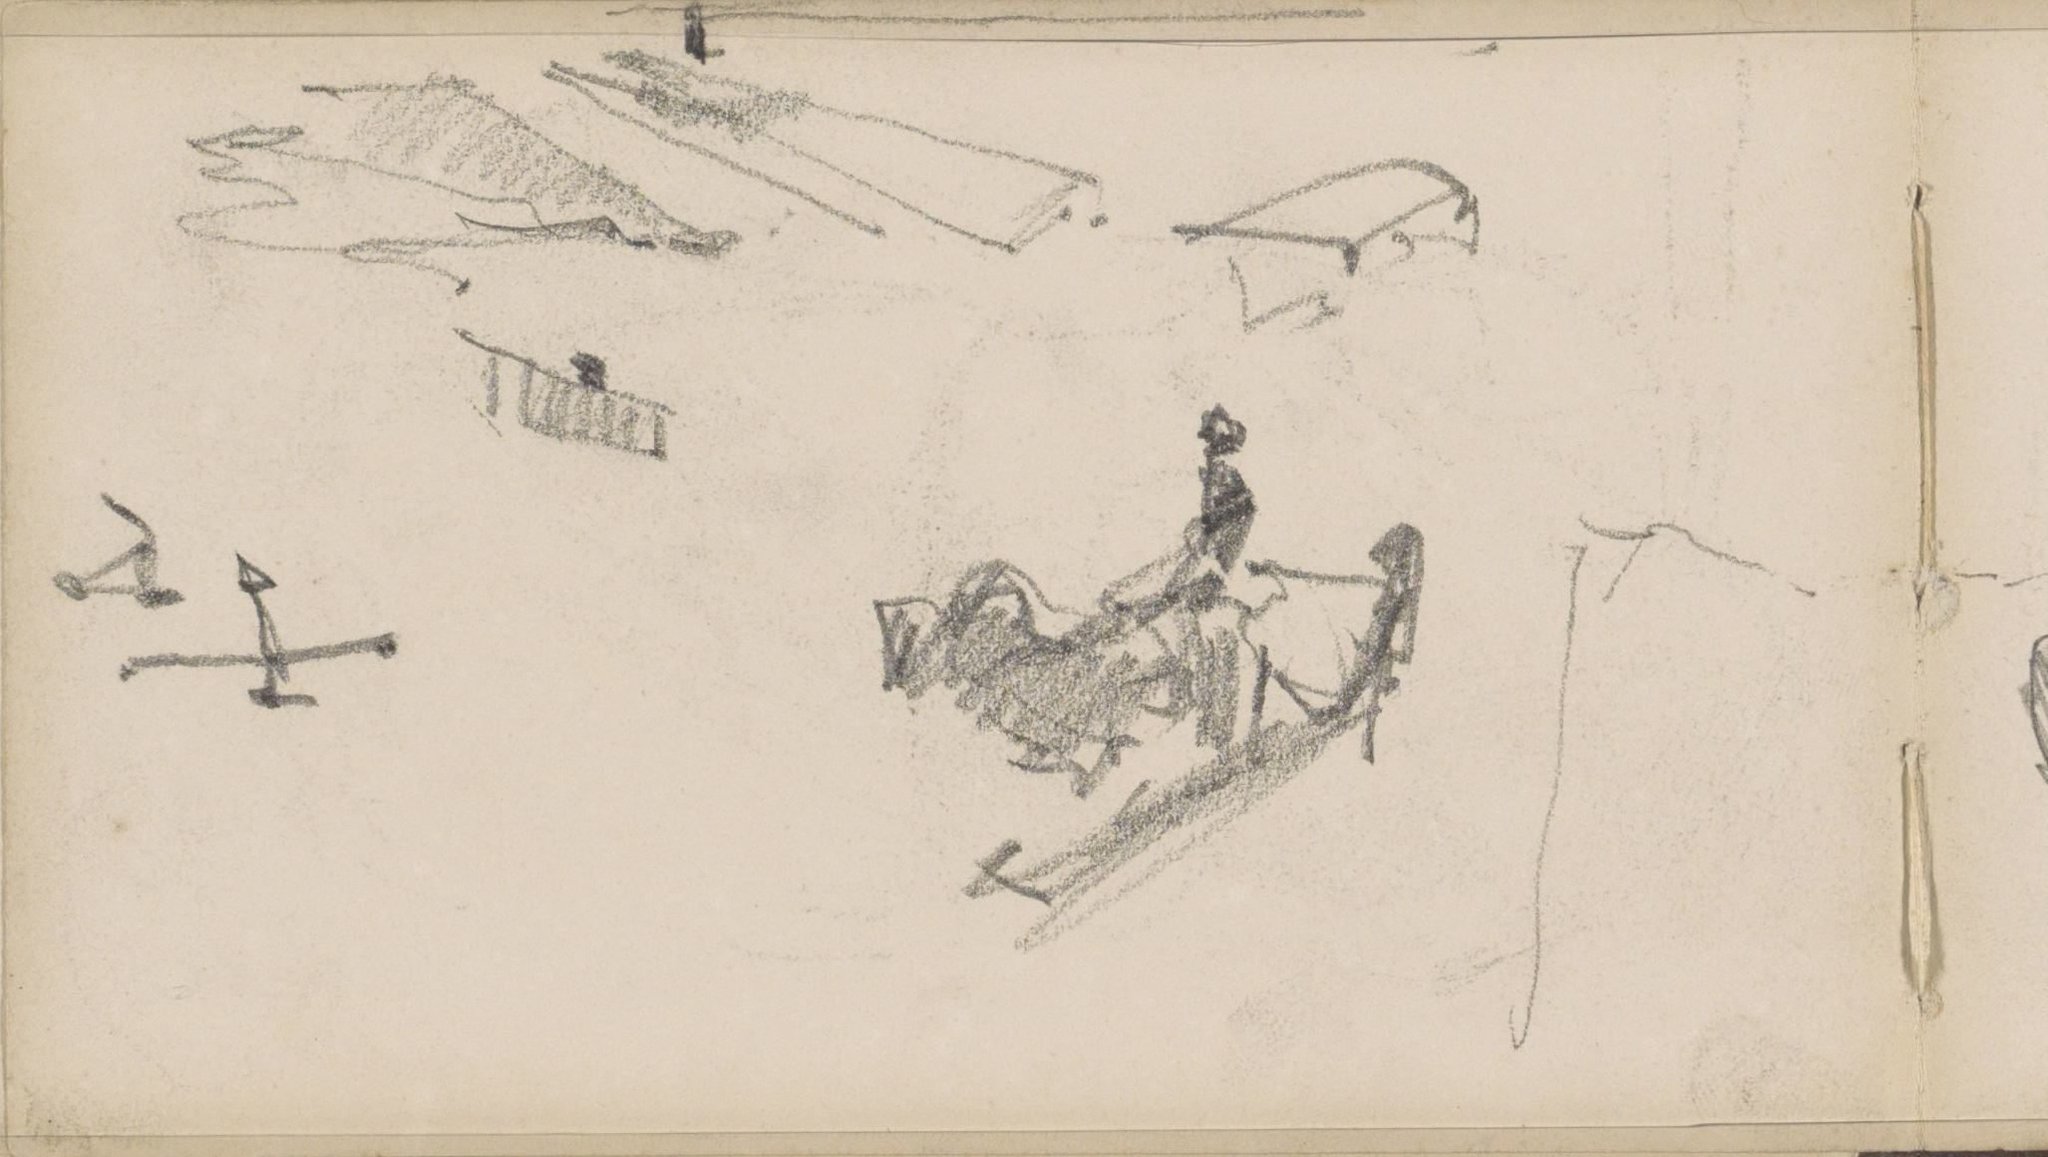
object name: sketchbook leaf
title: Studieblad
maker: george hendrik breitner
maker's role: draughtsman, painter, print maker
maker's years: 1857-1923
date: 1880-1882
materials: paper, pencil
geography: the hague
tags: riding a horse, ass, or mule; rider, horseman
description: Onder mogelijk een ruiter. Blad 13 verso uit een schetsboek met 16 bladen.